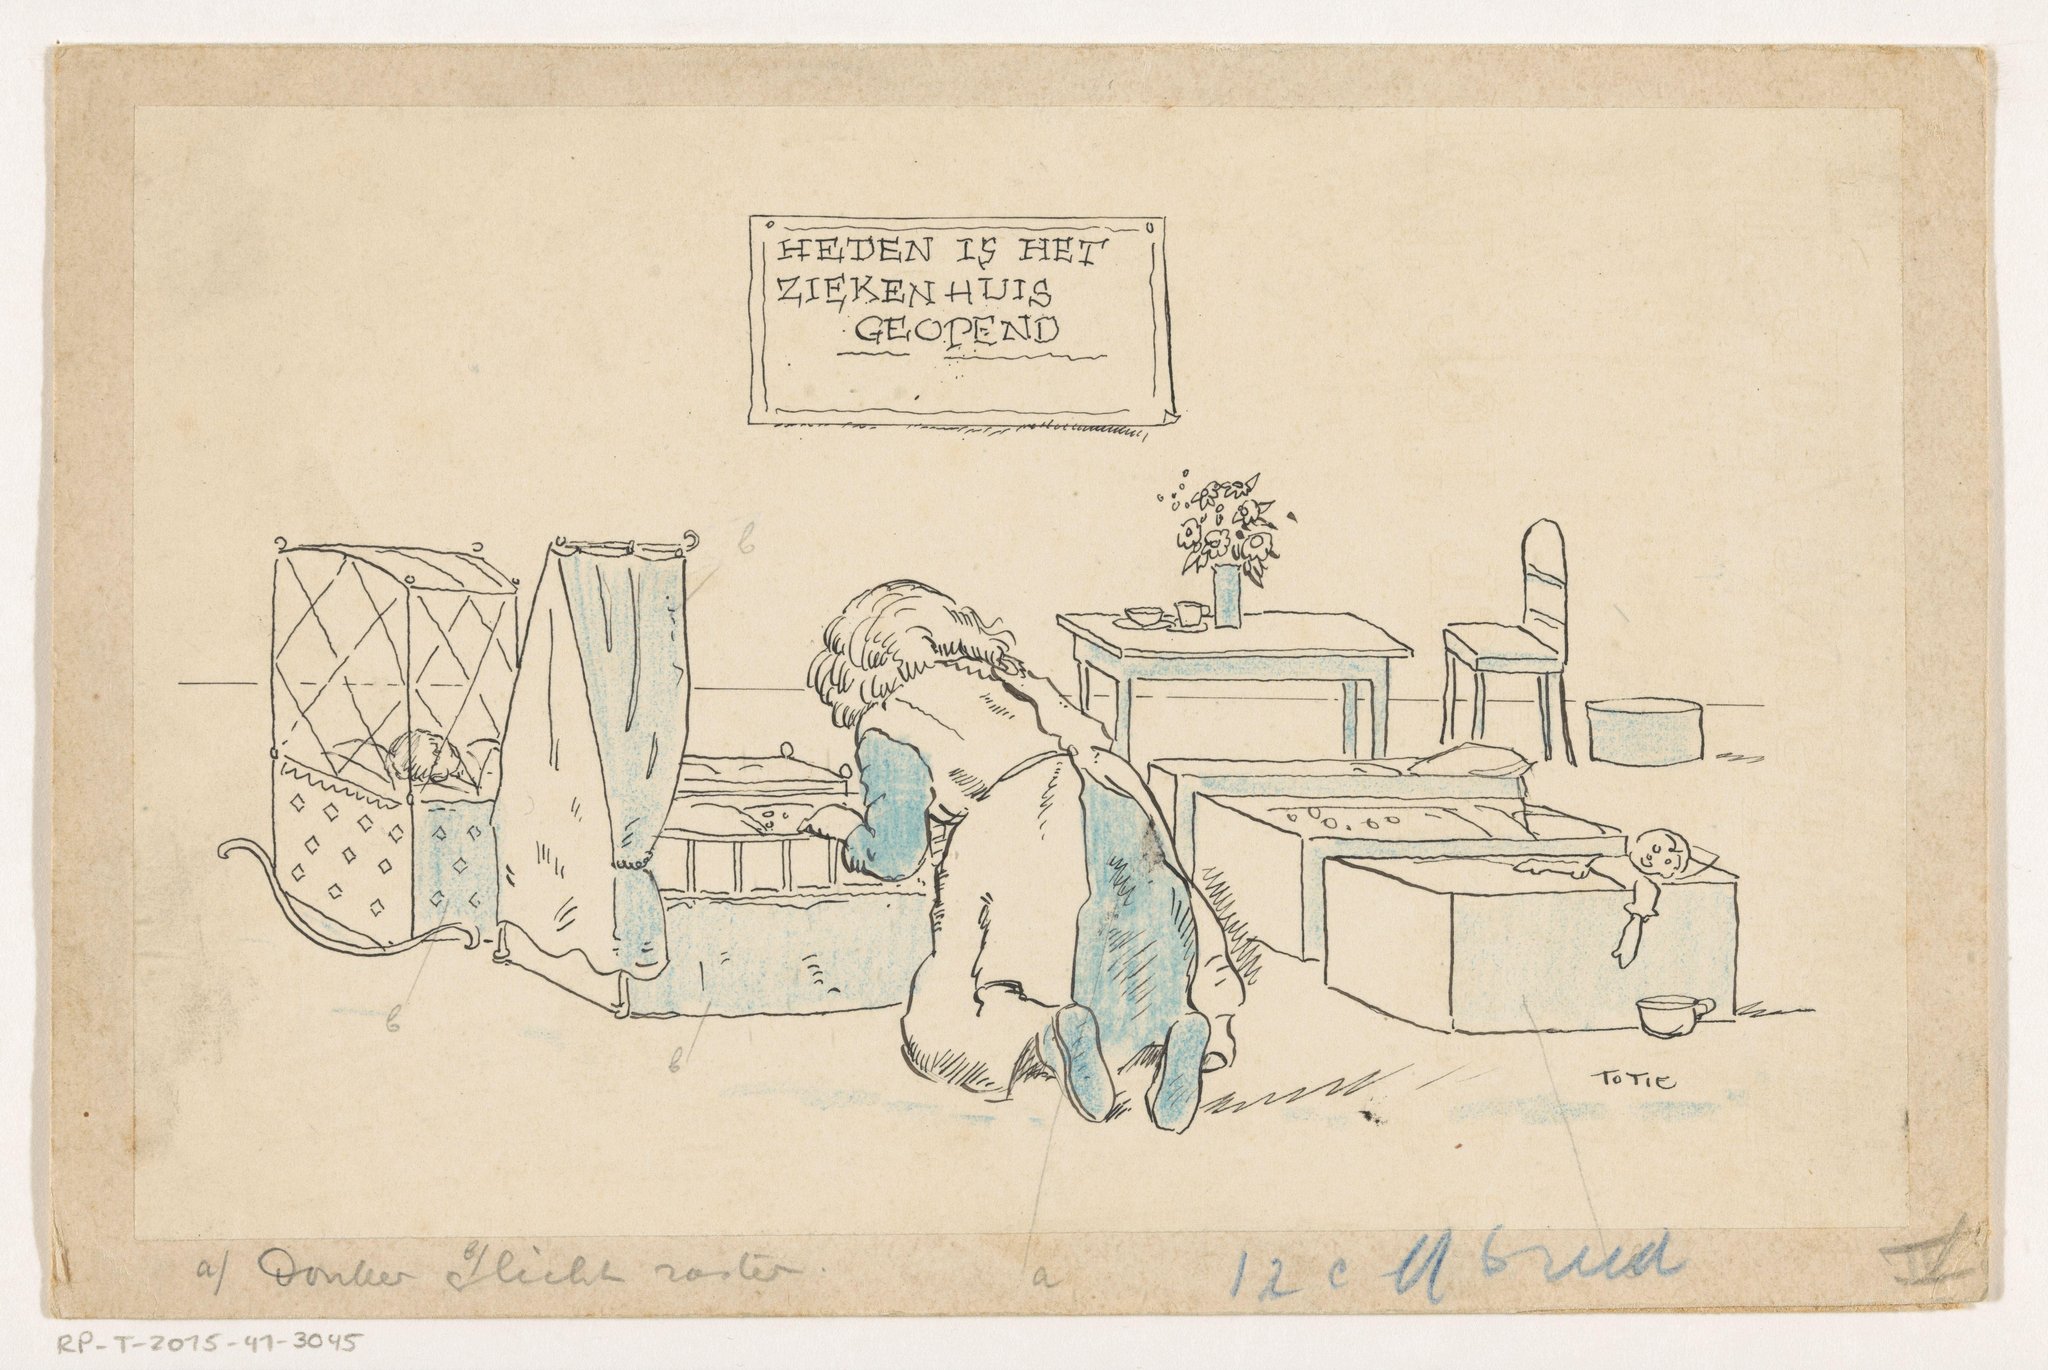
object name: boekillustratie ontwerp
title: Meisje speelt poppenziekenhuis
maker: totie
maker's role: draughtsman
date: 1890-1930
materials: cardboard, ink, paper, pencil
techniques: pen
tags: (playing with) dolls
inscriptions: collector's mark: Lugt 2228a, signature: ‘TOTIE’, number: ‘IV’, :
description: Een meisje zit geknield op de grond bij een poppenbed gemaakt van een schoendoos. In het bed ligt een 'zieke' pop. In de kamer staan nog vier bedden en een tafel en stoel van miniatuurformaat. Aan de muur hangt een bord met de tekst 'Heden is het ziekenhuis geopend'.